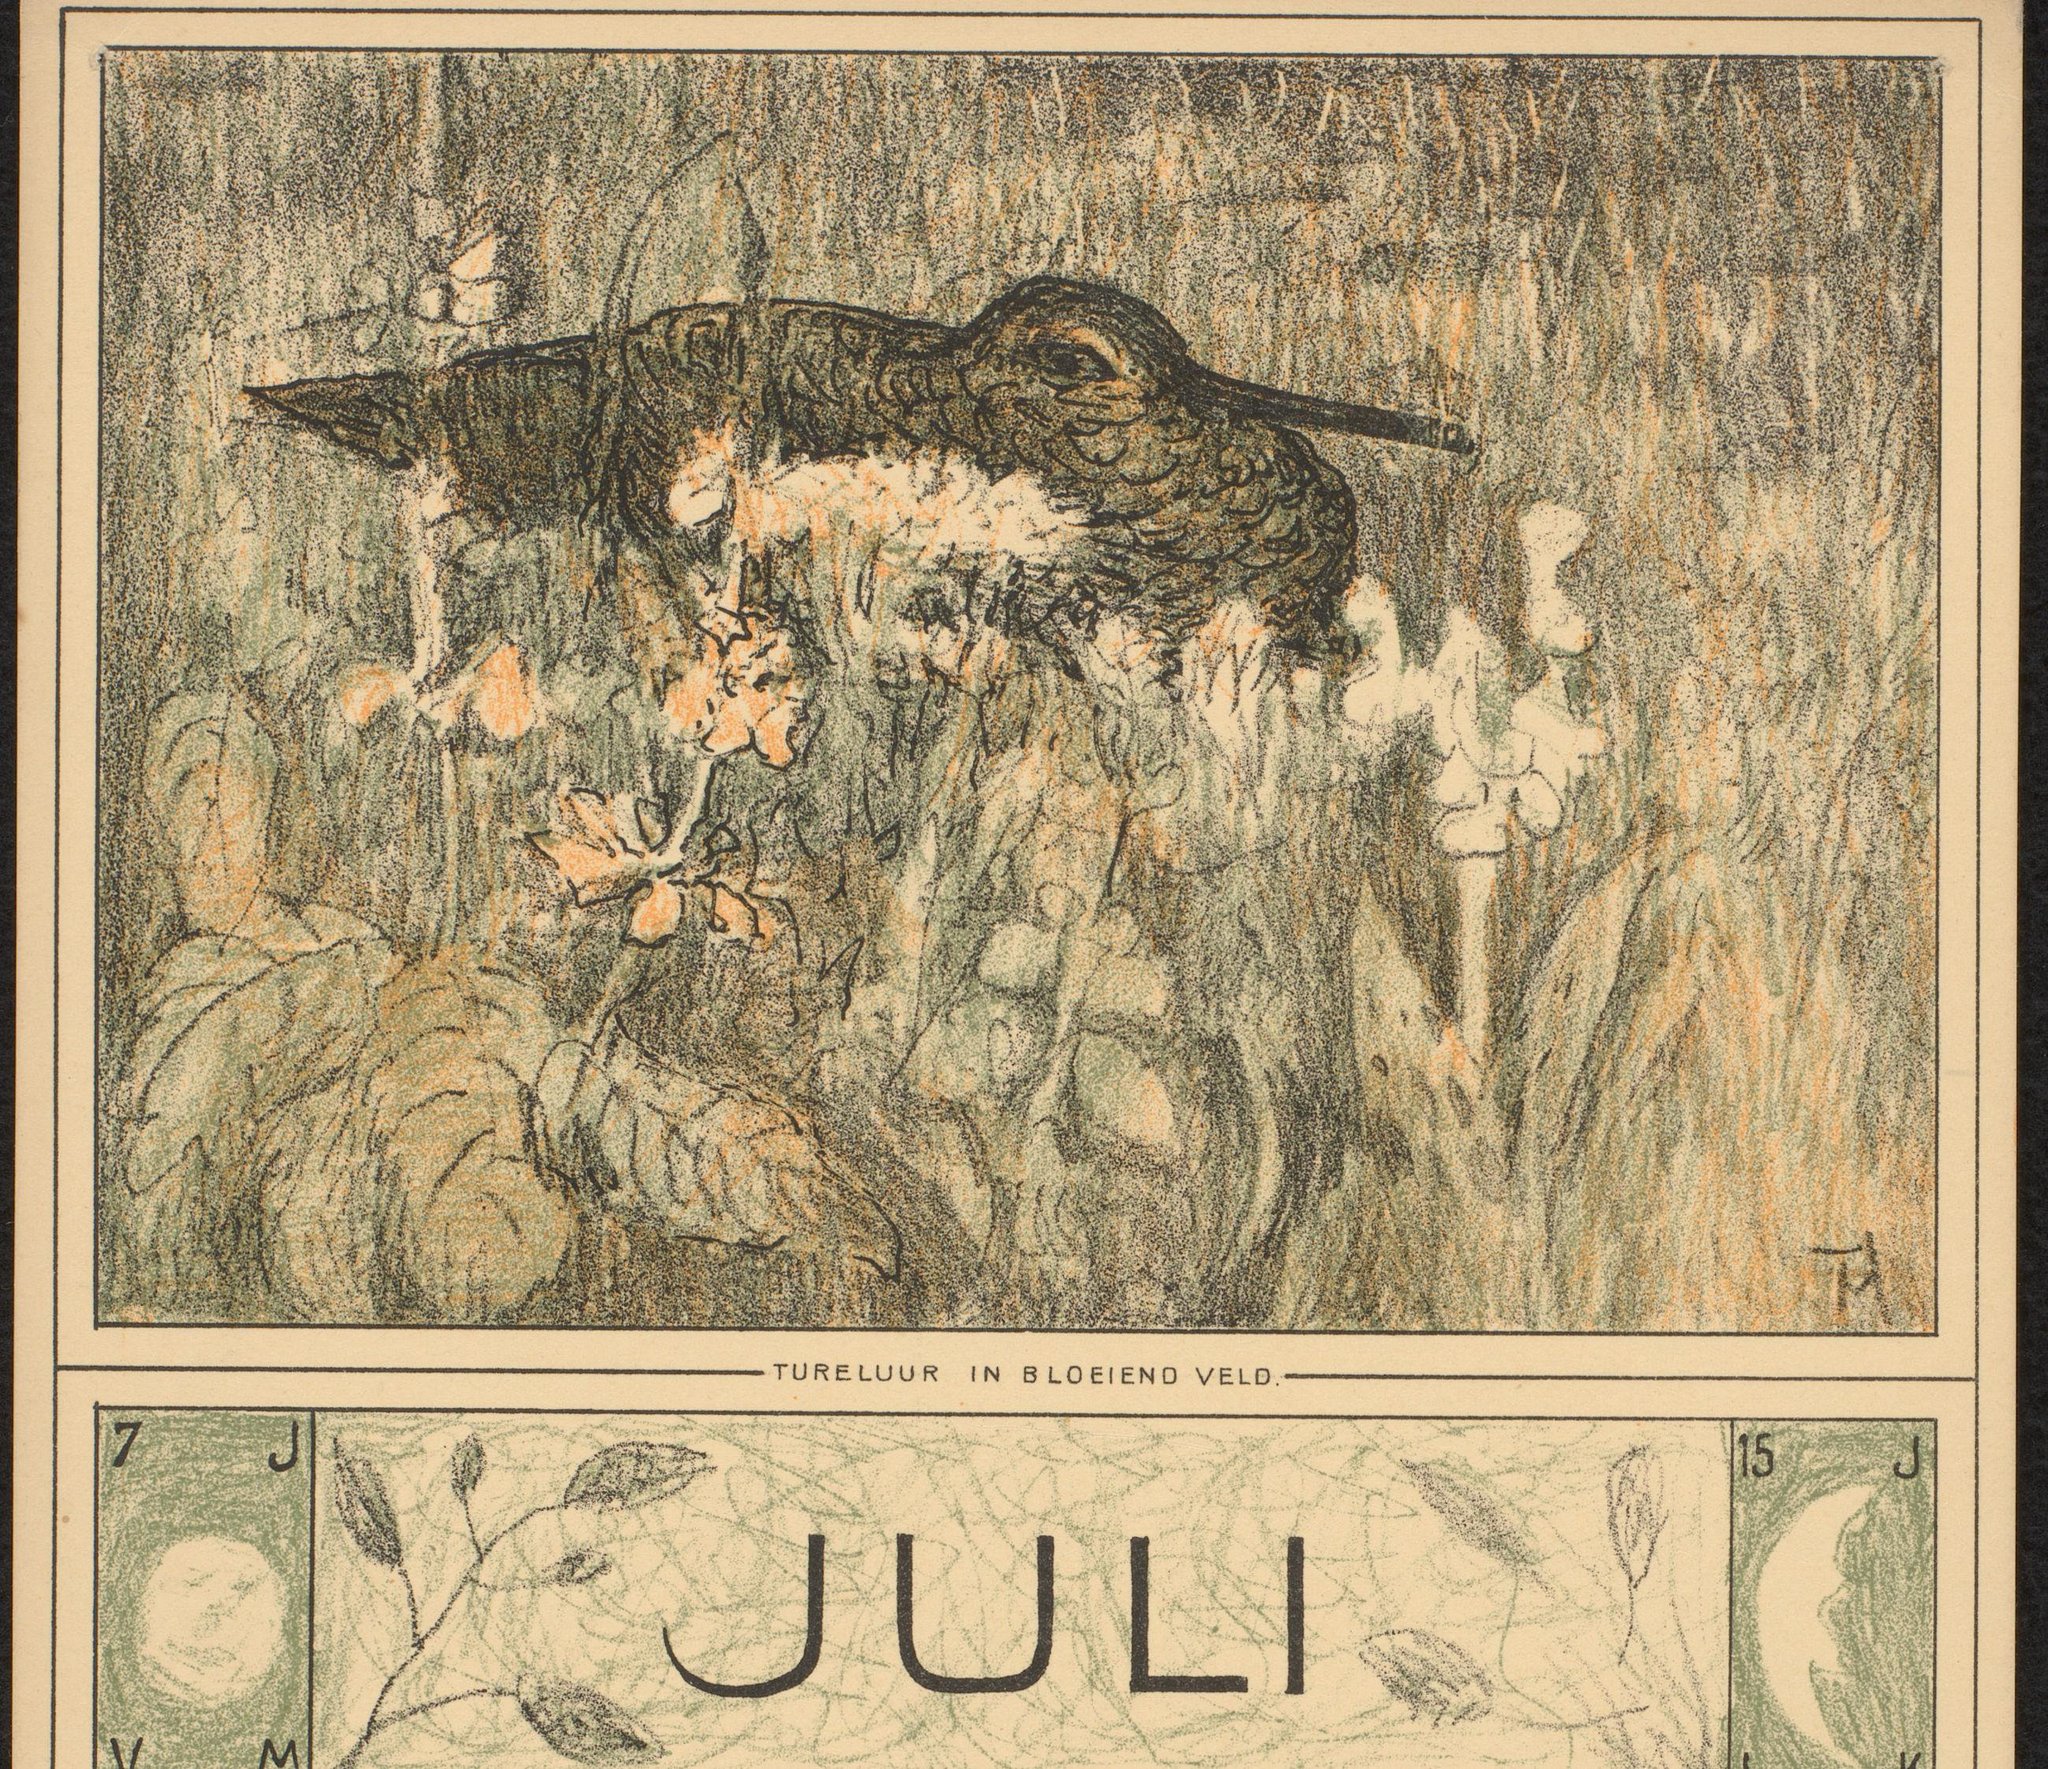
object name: calendar leaf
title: Kalenderblad voor juli 1914 met een tureluur in een landschap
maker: theo van hoytema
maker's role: draughtsman, painter, print maker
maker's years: 1863-1917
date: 1913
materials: paper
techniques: lithograph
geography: amsterdam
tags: calendar, almanac, birds